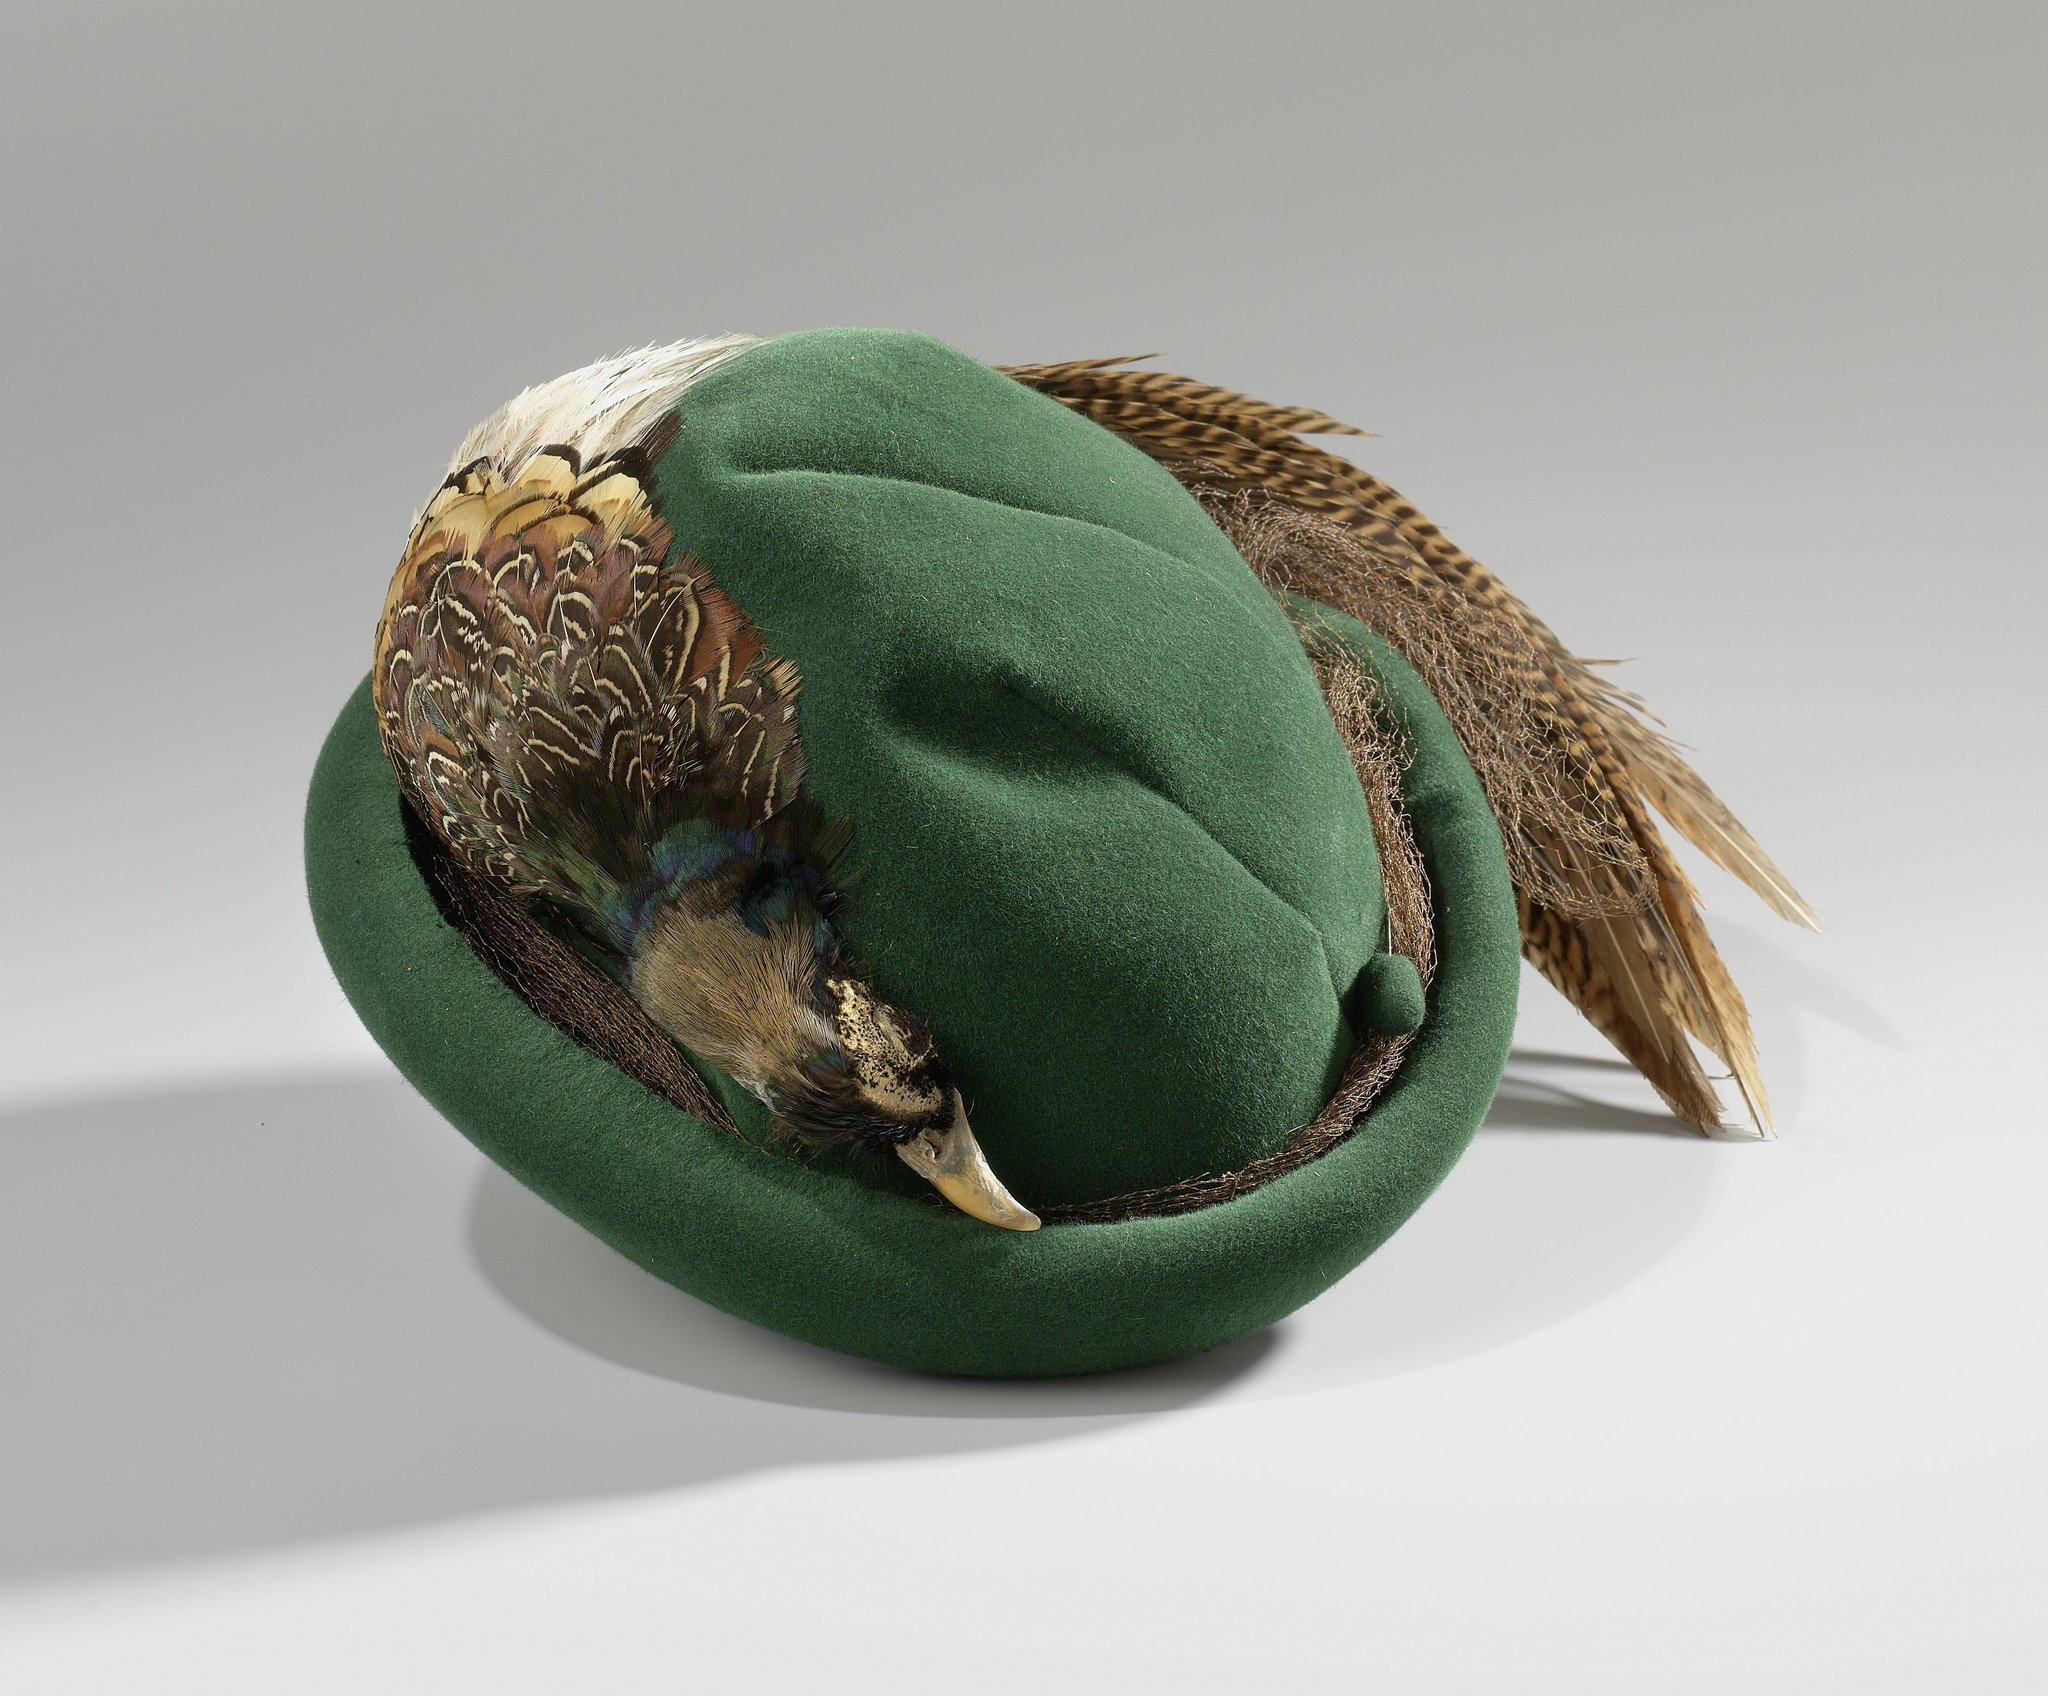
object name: cloche dameshoed, pothoed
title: Hat with a Pheasant Decoration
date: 1945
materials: feather, felt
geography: paris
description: From 1945 hats became smaller in reaction to the large models that had been fashionable during World War II. This hat, made by the Legroux Soeurs (Legroux sisters), famous Paris modistes, is an early example of this trend. Mrs Brusse-Urtebise bought her hats in Paris. The same model can be seen in a French magazine of October 1945.